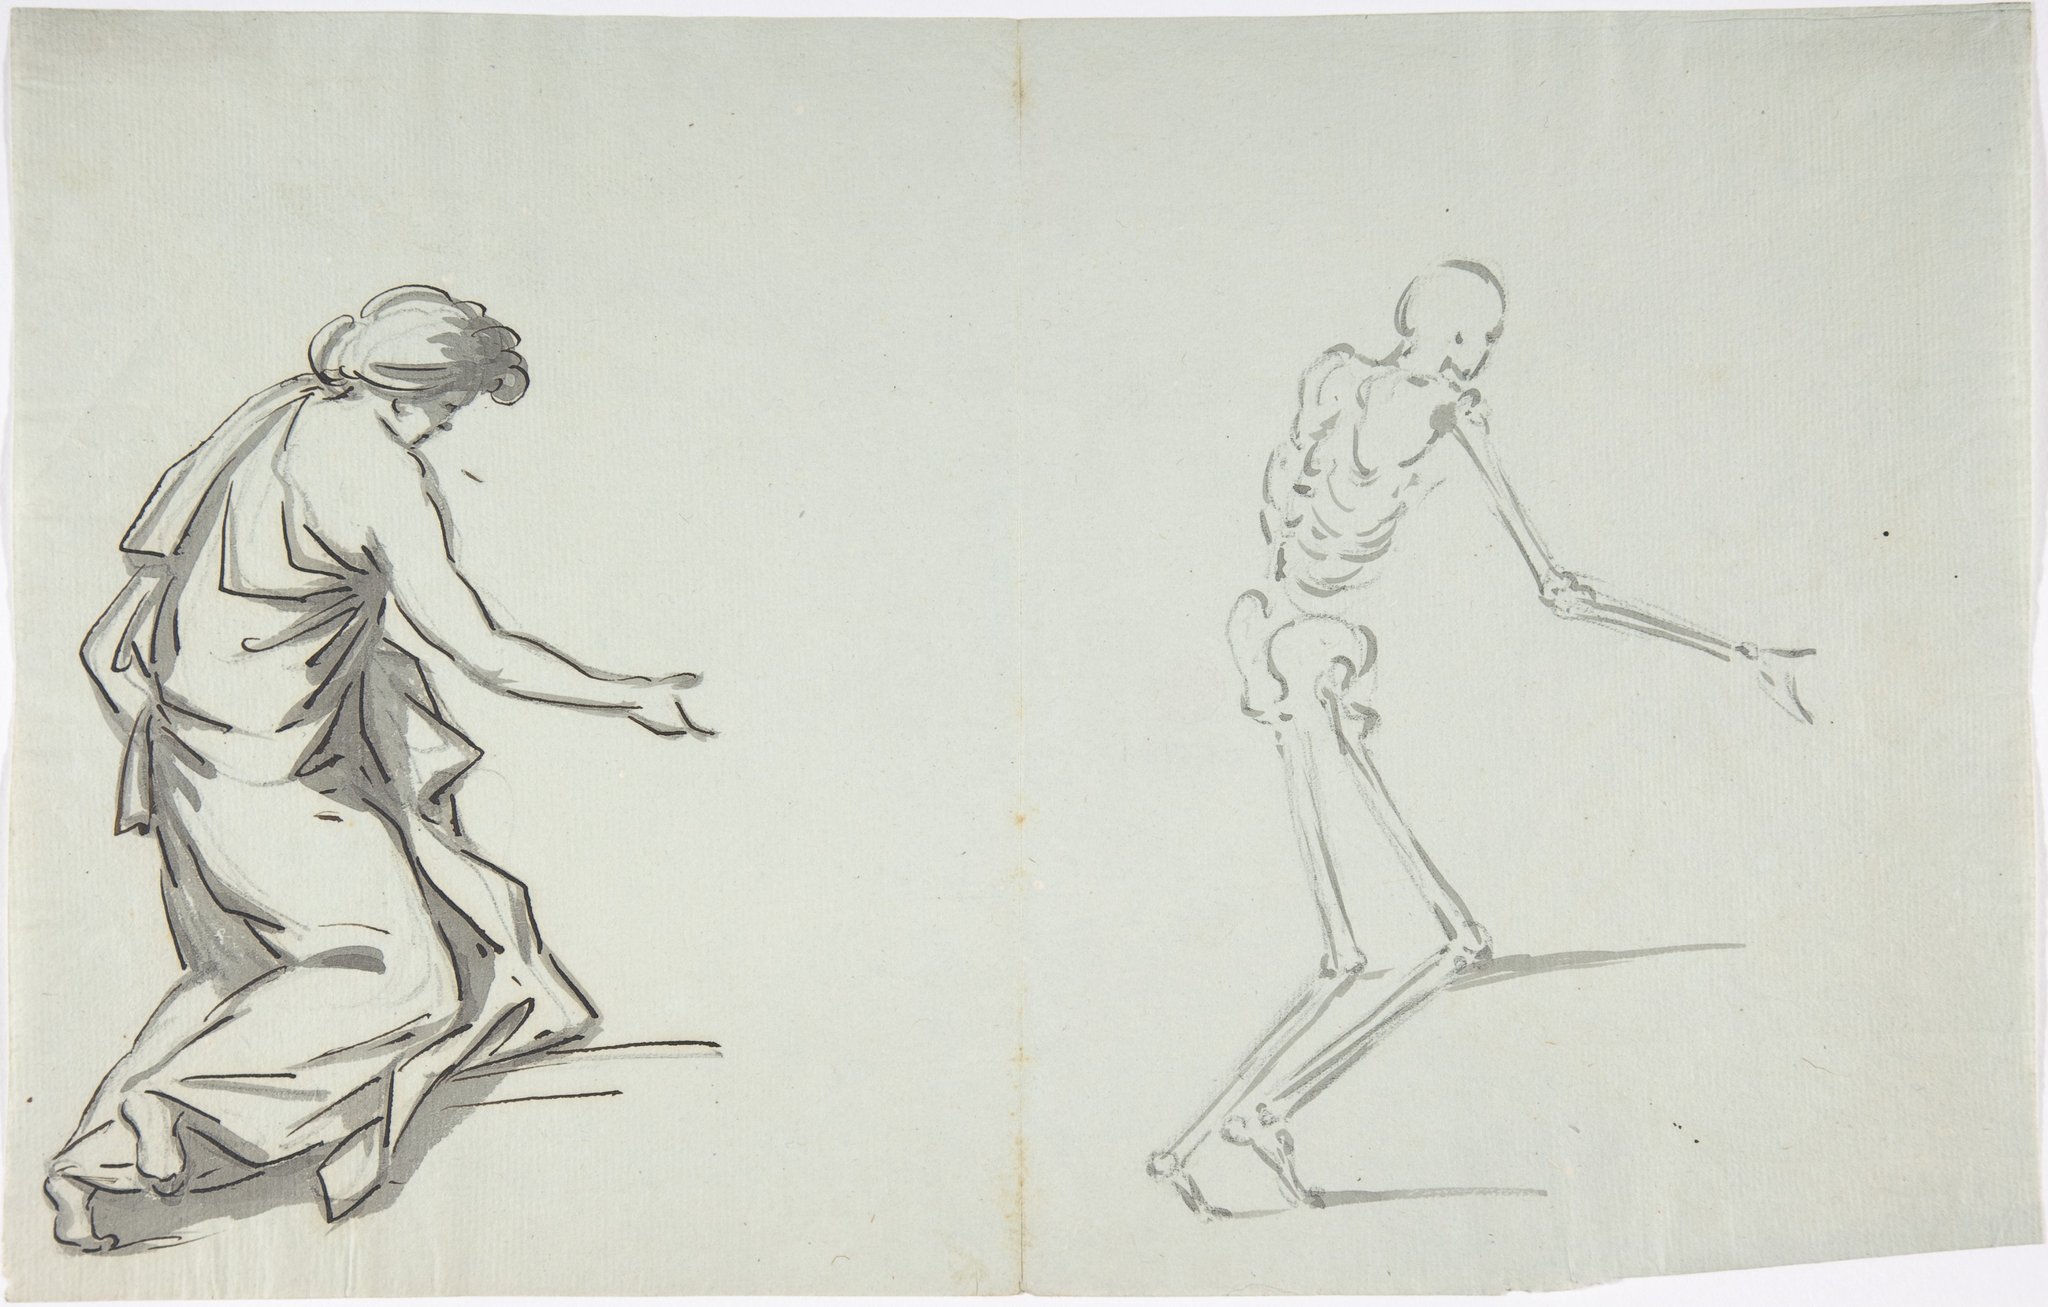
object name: drawing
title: Anatomical drawing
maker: anonymous, french, 18th century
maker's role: artist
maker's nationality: french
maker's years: 1700-1800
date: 1701-1800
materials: ink, paper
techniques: brush, pen, wash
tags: skeletons,women